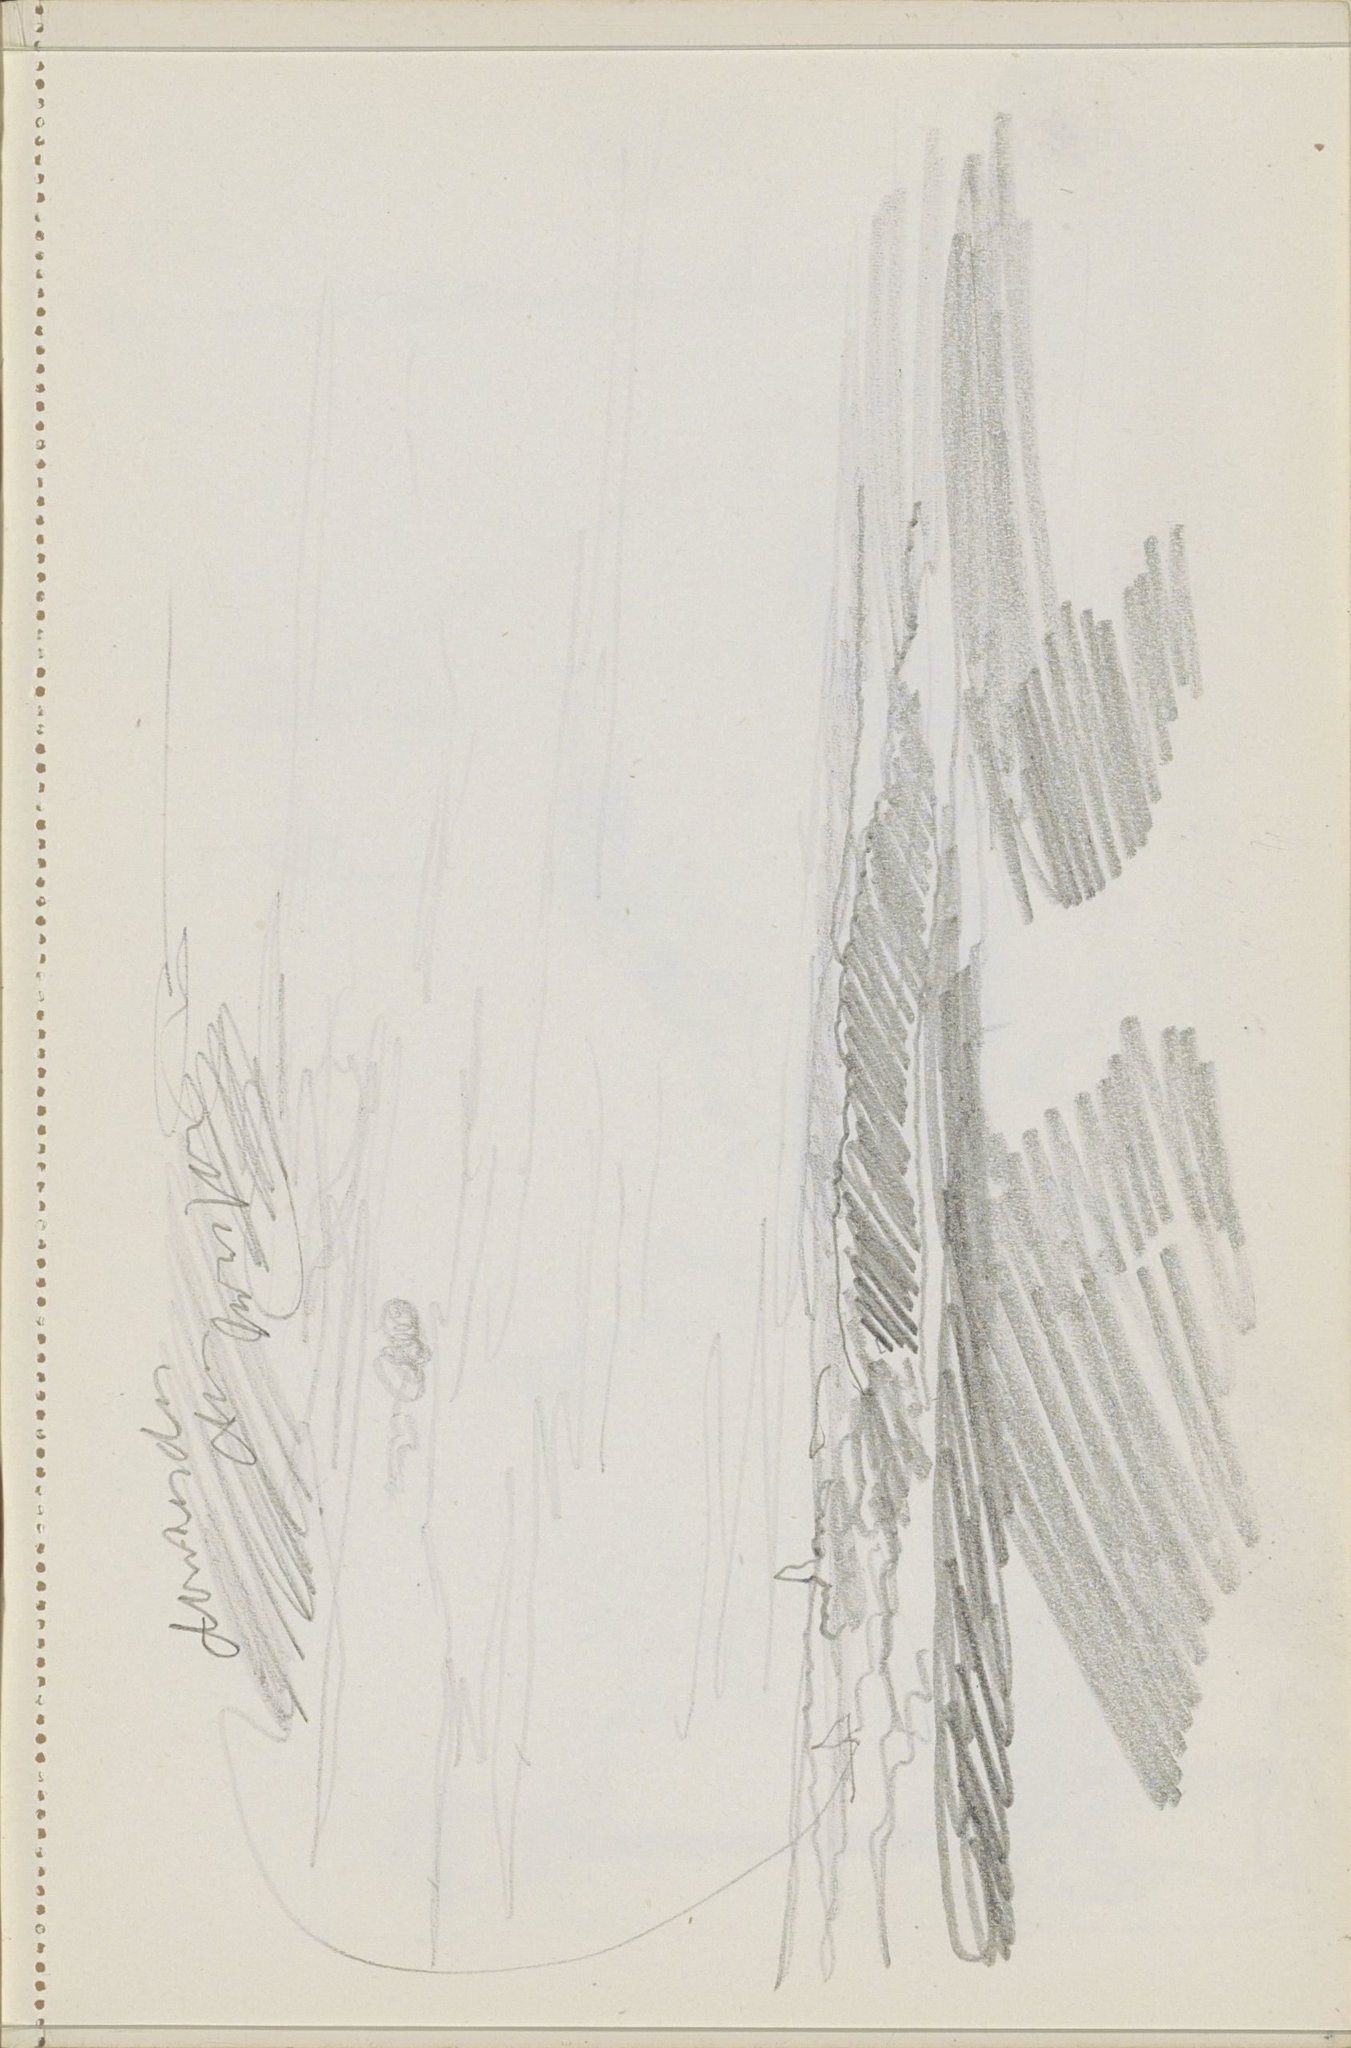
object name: sketchbook leaf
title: Zeegezicht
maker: cornelis vreedenburgh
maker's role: draughtsman, print maker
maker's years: 1880-1946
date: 1890-1946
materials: paper, pencil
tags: sea (seascape)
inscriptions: kleurnotitie, handgeschreven in potlood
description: Blad 58 recto uit een schetsboek met uit 75 bladen.